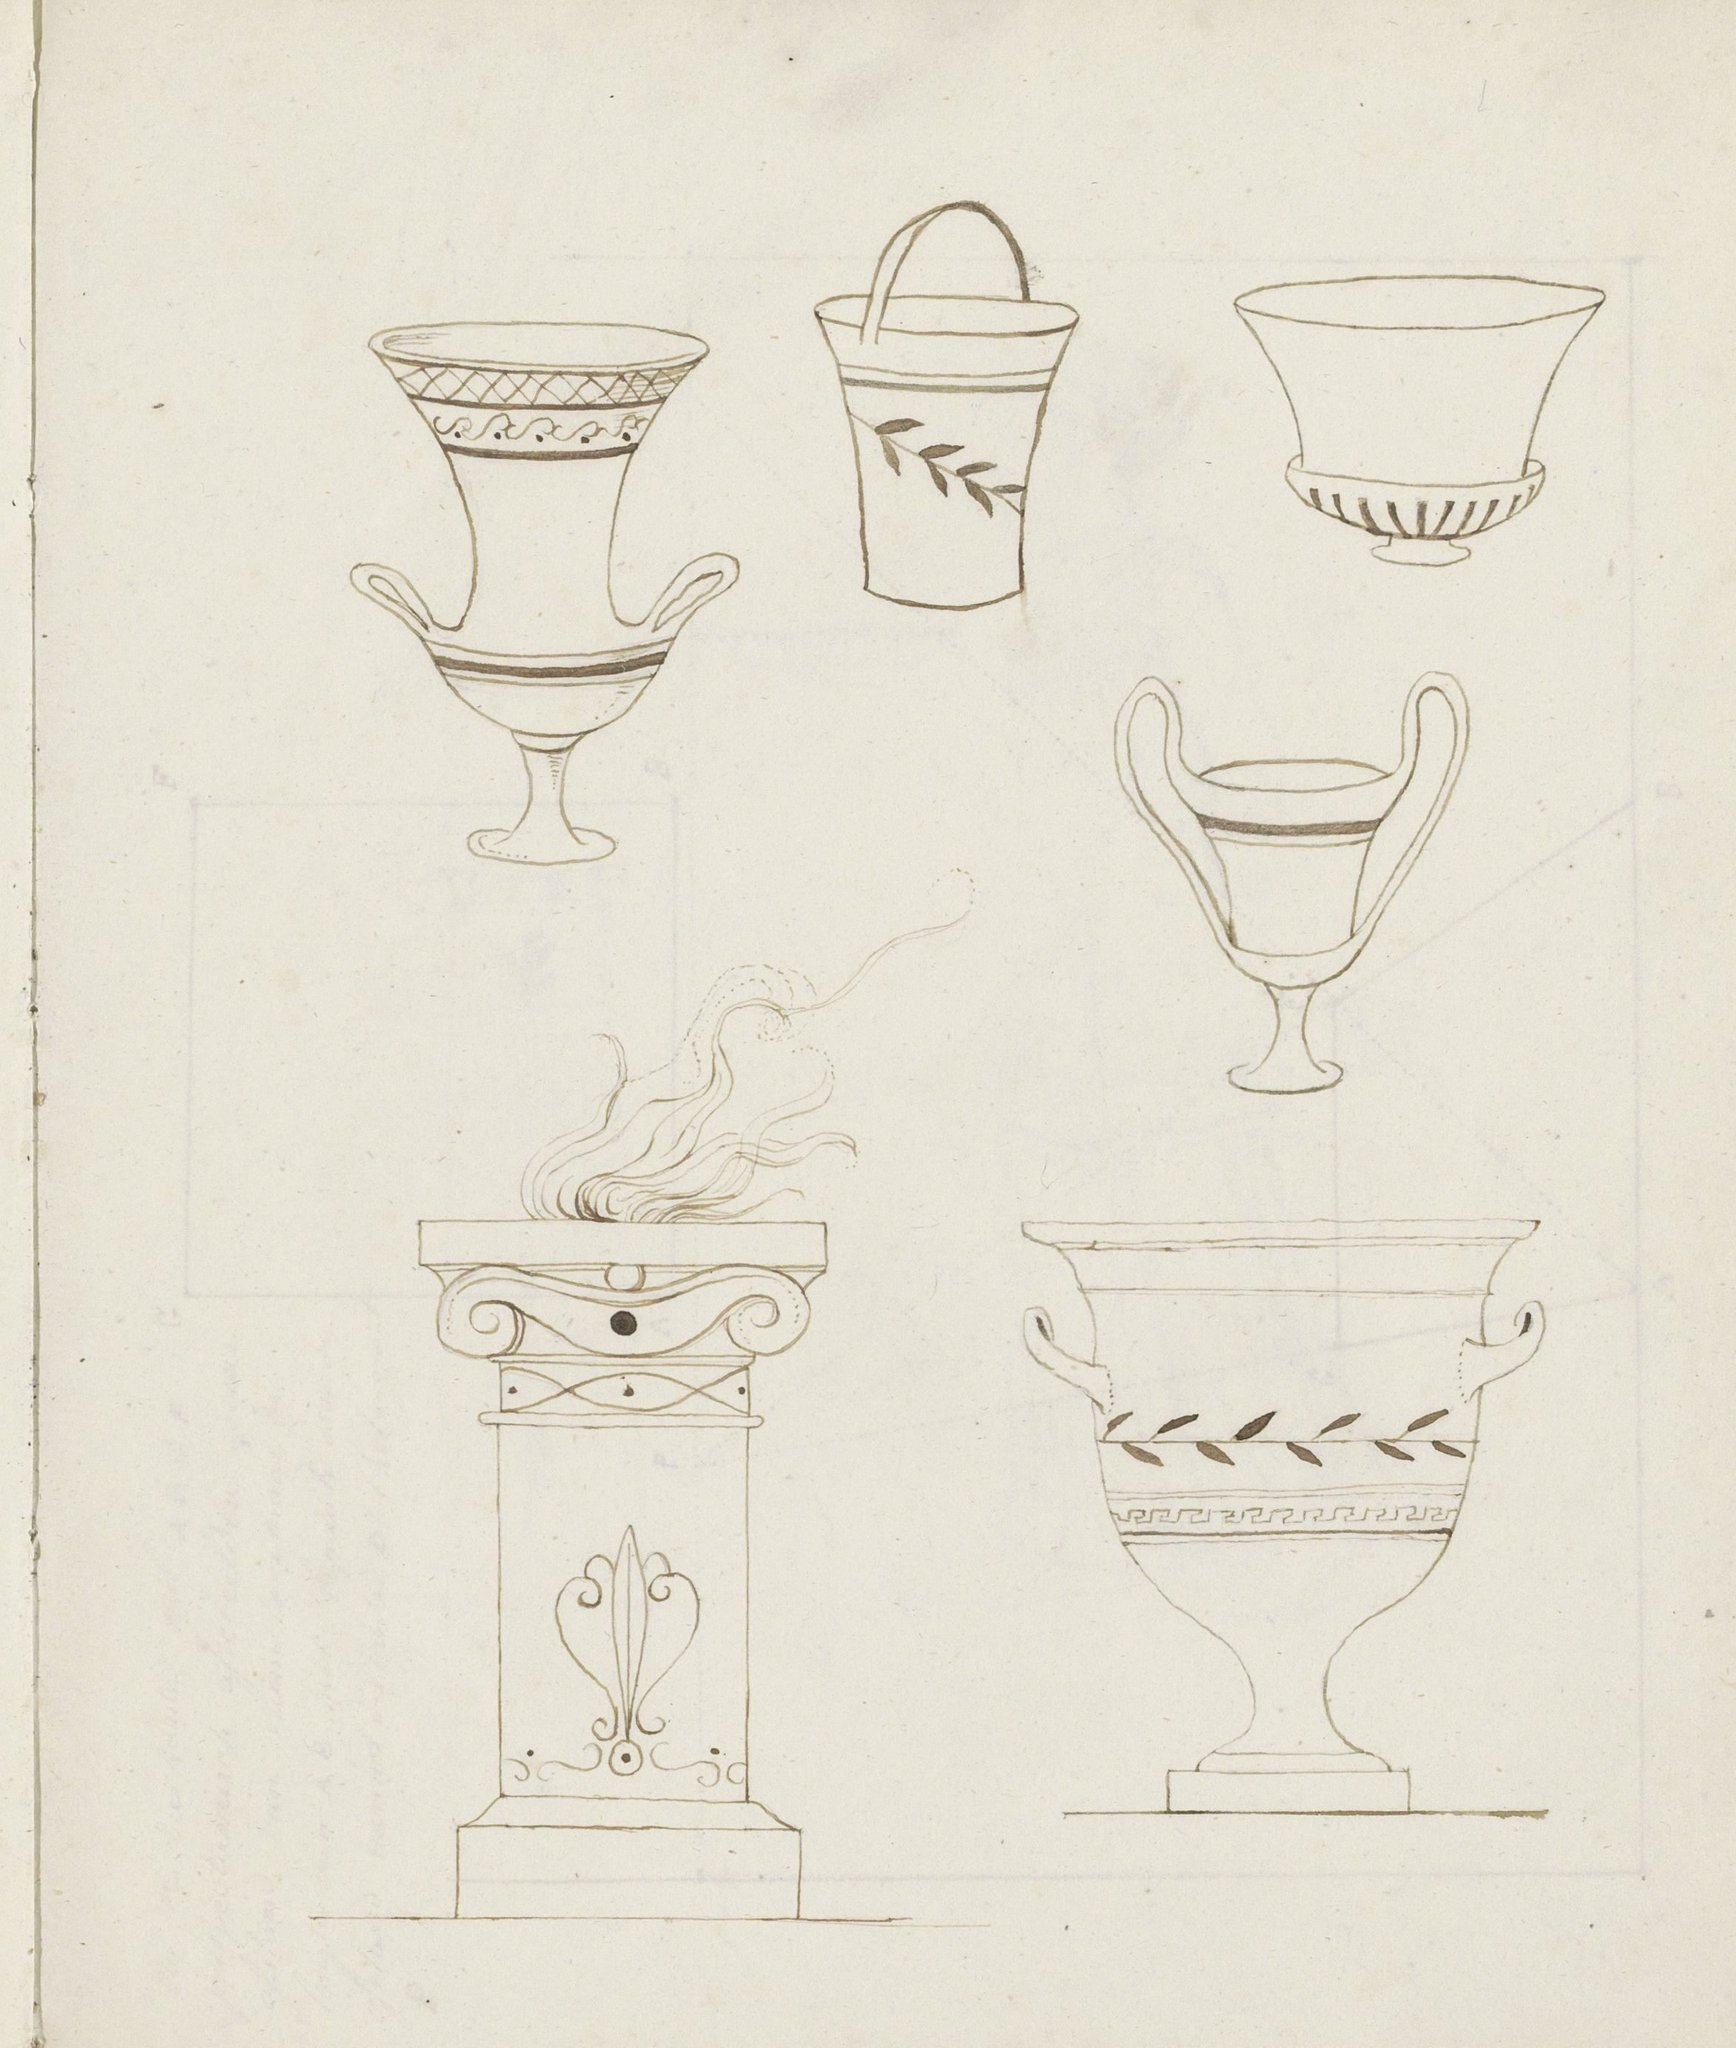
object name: sketchbook leaf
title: Griekse vazen en een altaar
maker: jonkvrouw elisabeth kemper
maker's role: draughtsman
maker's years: 1799-1871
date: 1815-1852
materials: ink, paper, pencil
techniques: pen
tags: altar ~ greek religion, container of stone: stone vase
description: Blad 5 recto uit een schetsboek met 94 bladen.